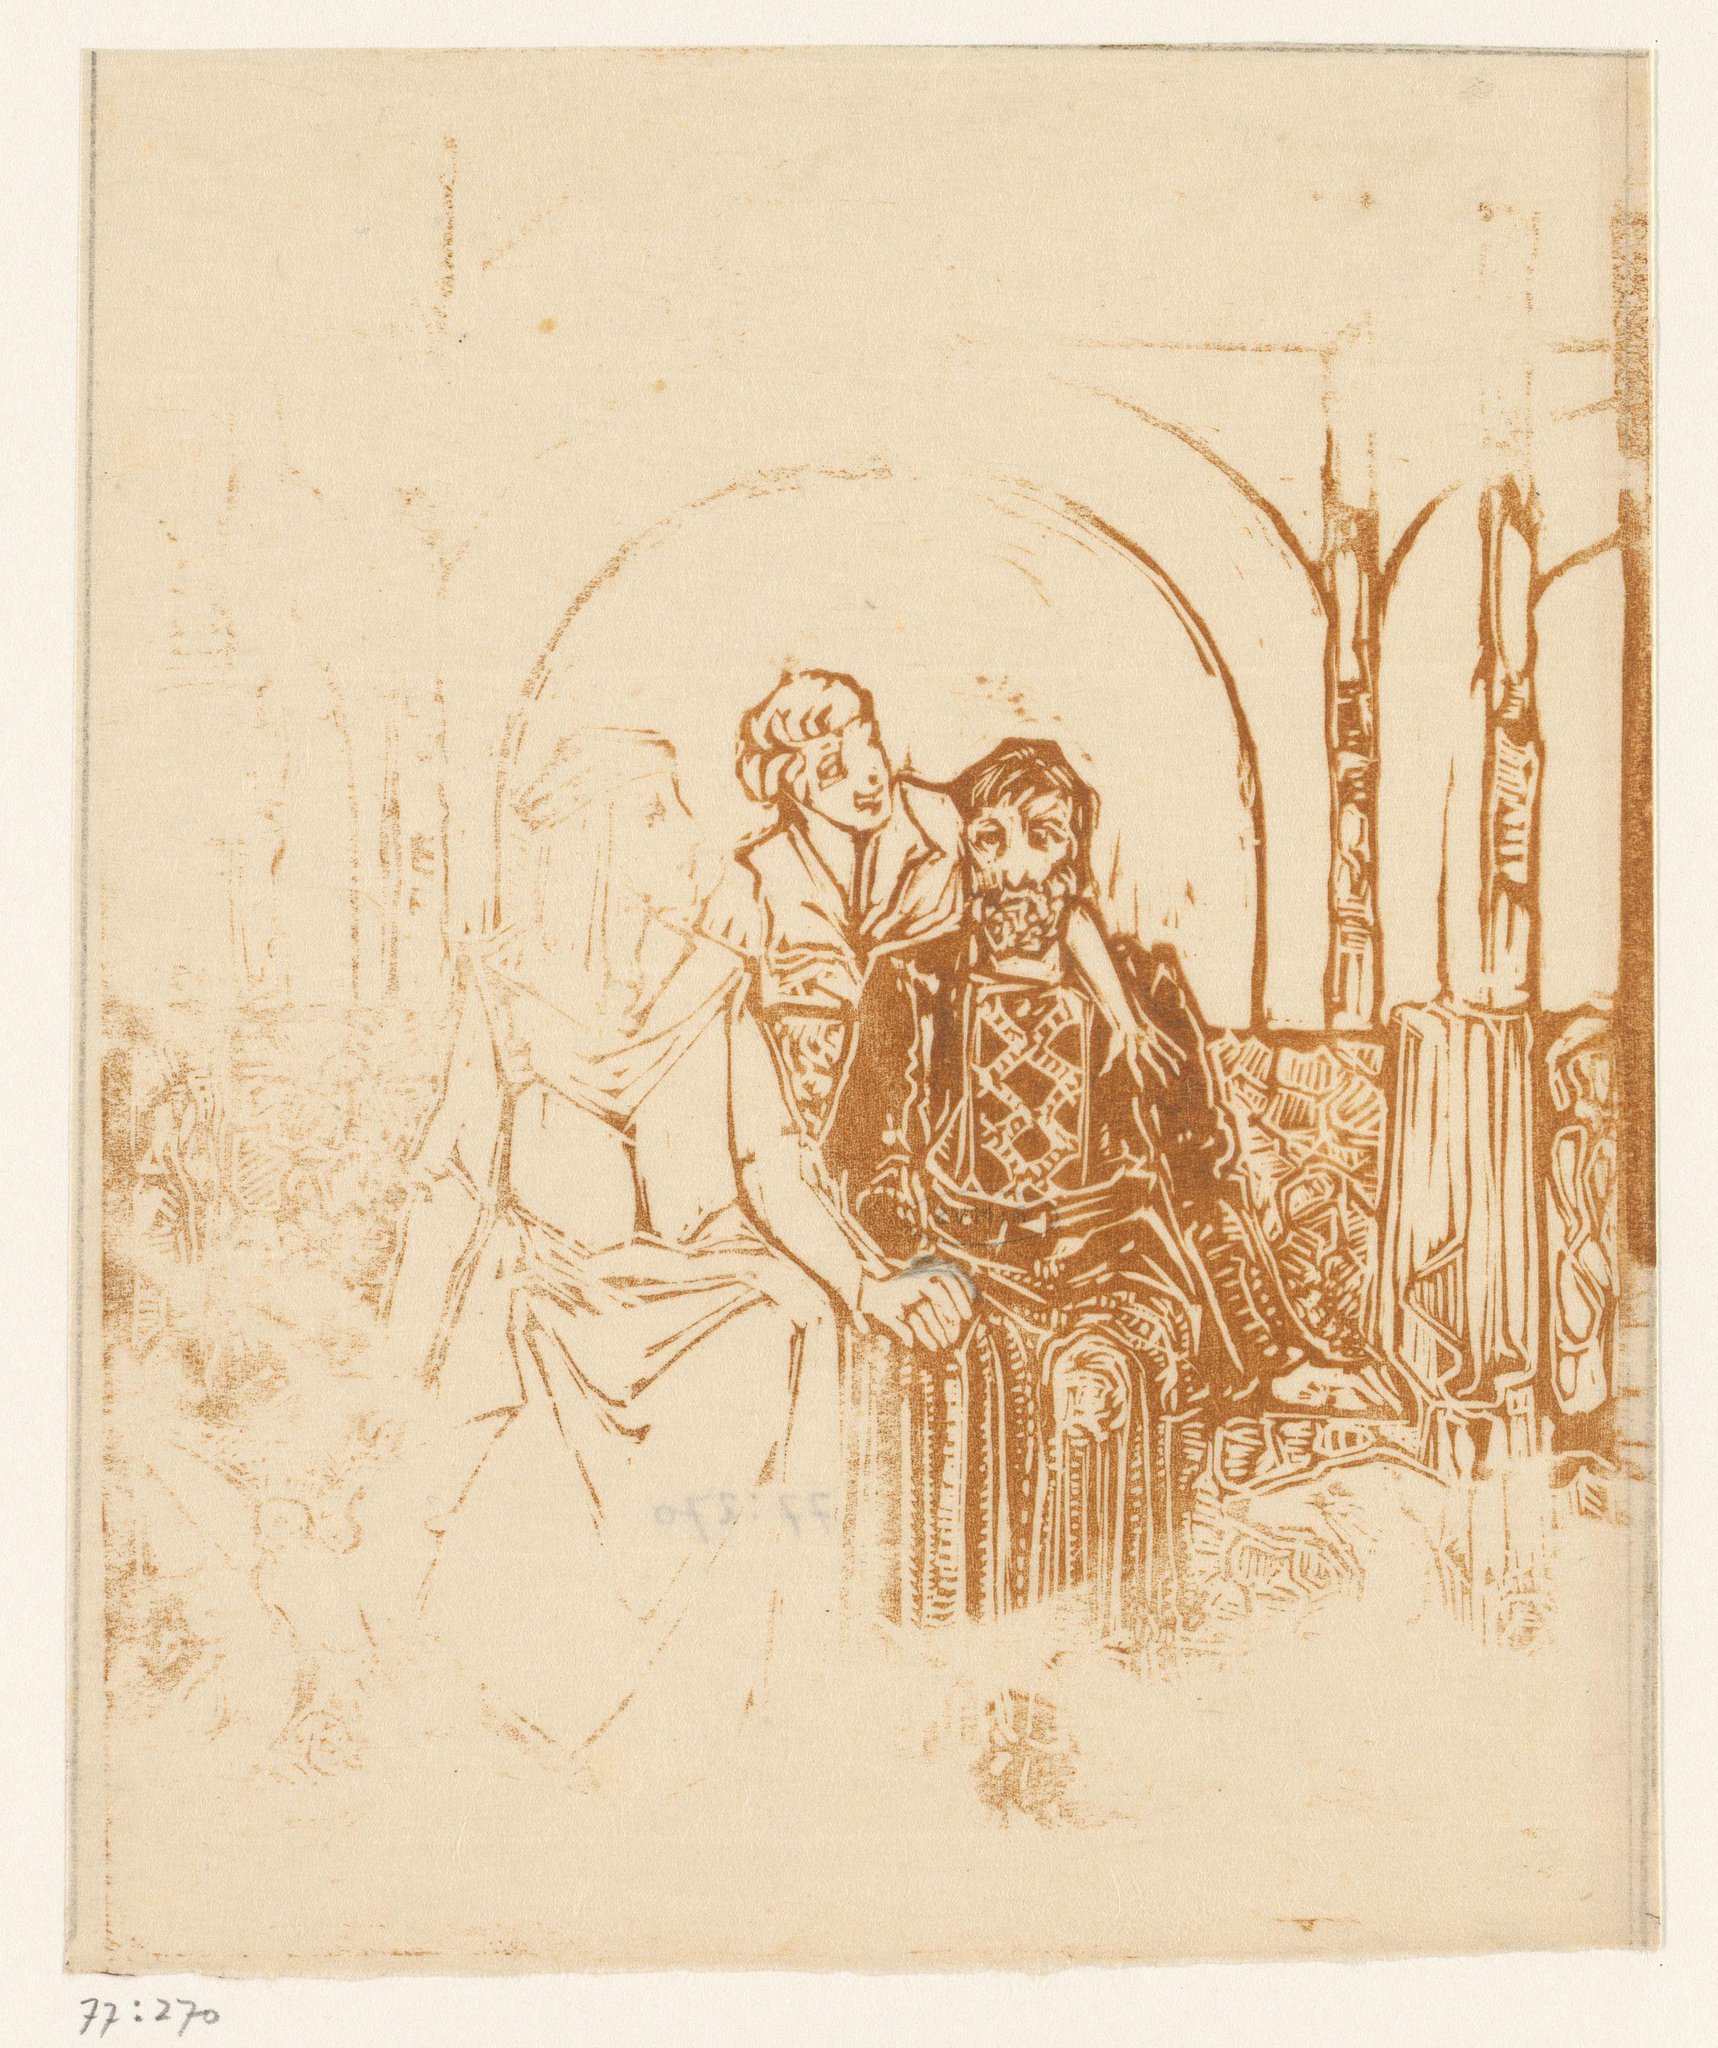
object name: print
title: Zittend paar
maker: bernard willem wierink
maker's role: draughtsman, print maker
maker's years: 1856-1939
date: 1938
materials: paper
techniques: relief print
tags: couple of lovers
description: Deze vroege proefdruk nog zonder de poort met drie torens die in latere proefdrukken in de achtergrond verschijnt. Ook zijn de hond en drie duiven aan de voeten van de figuren nog niet duidelijk toegevoegd. Illustratie voor een uitgave van een onbekend toneelstuk. Deze prent is vermoedelijk een plaatsnede, ook al wordt in de literatuur veelal gesproken over een houtsnede. Voor zover Wierink zijn prenten in hoogdruk zelf heeft omschreven, heeft hij altijd de term 'plaatsnede' gebruikt.